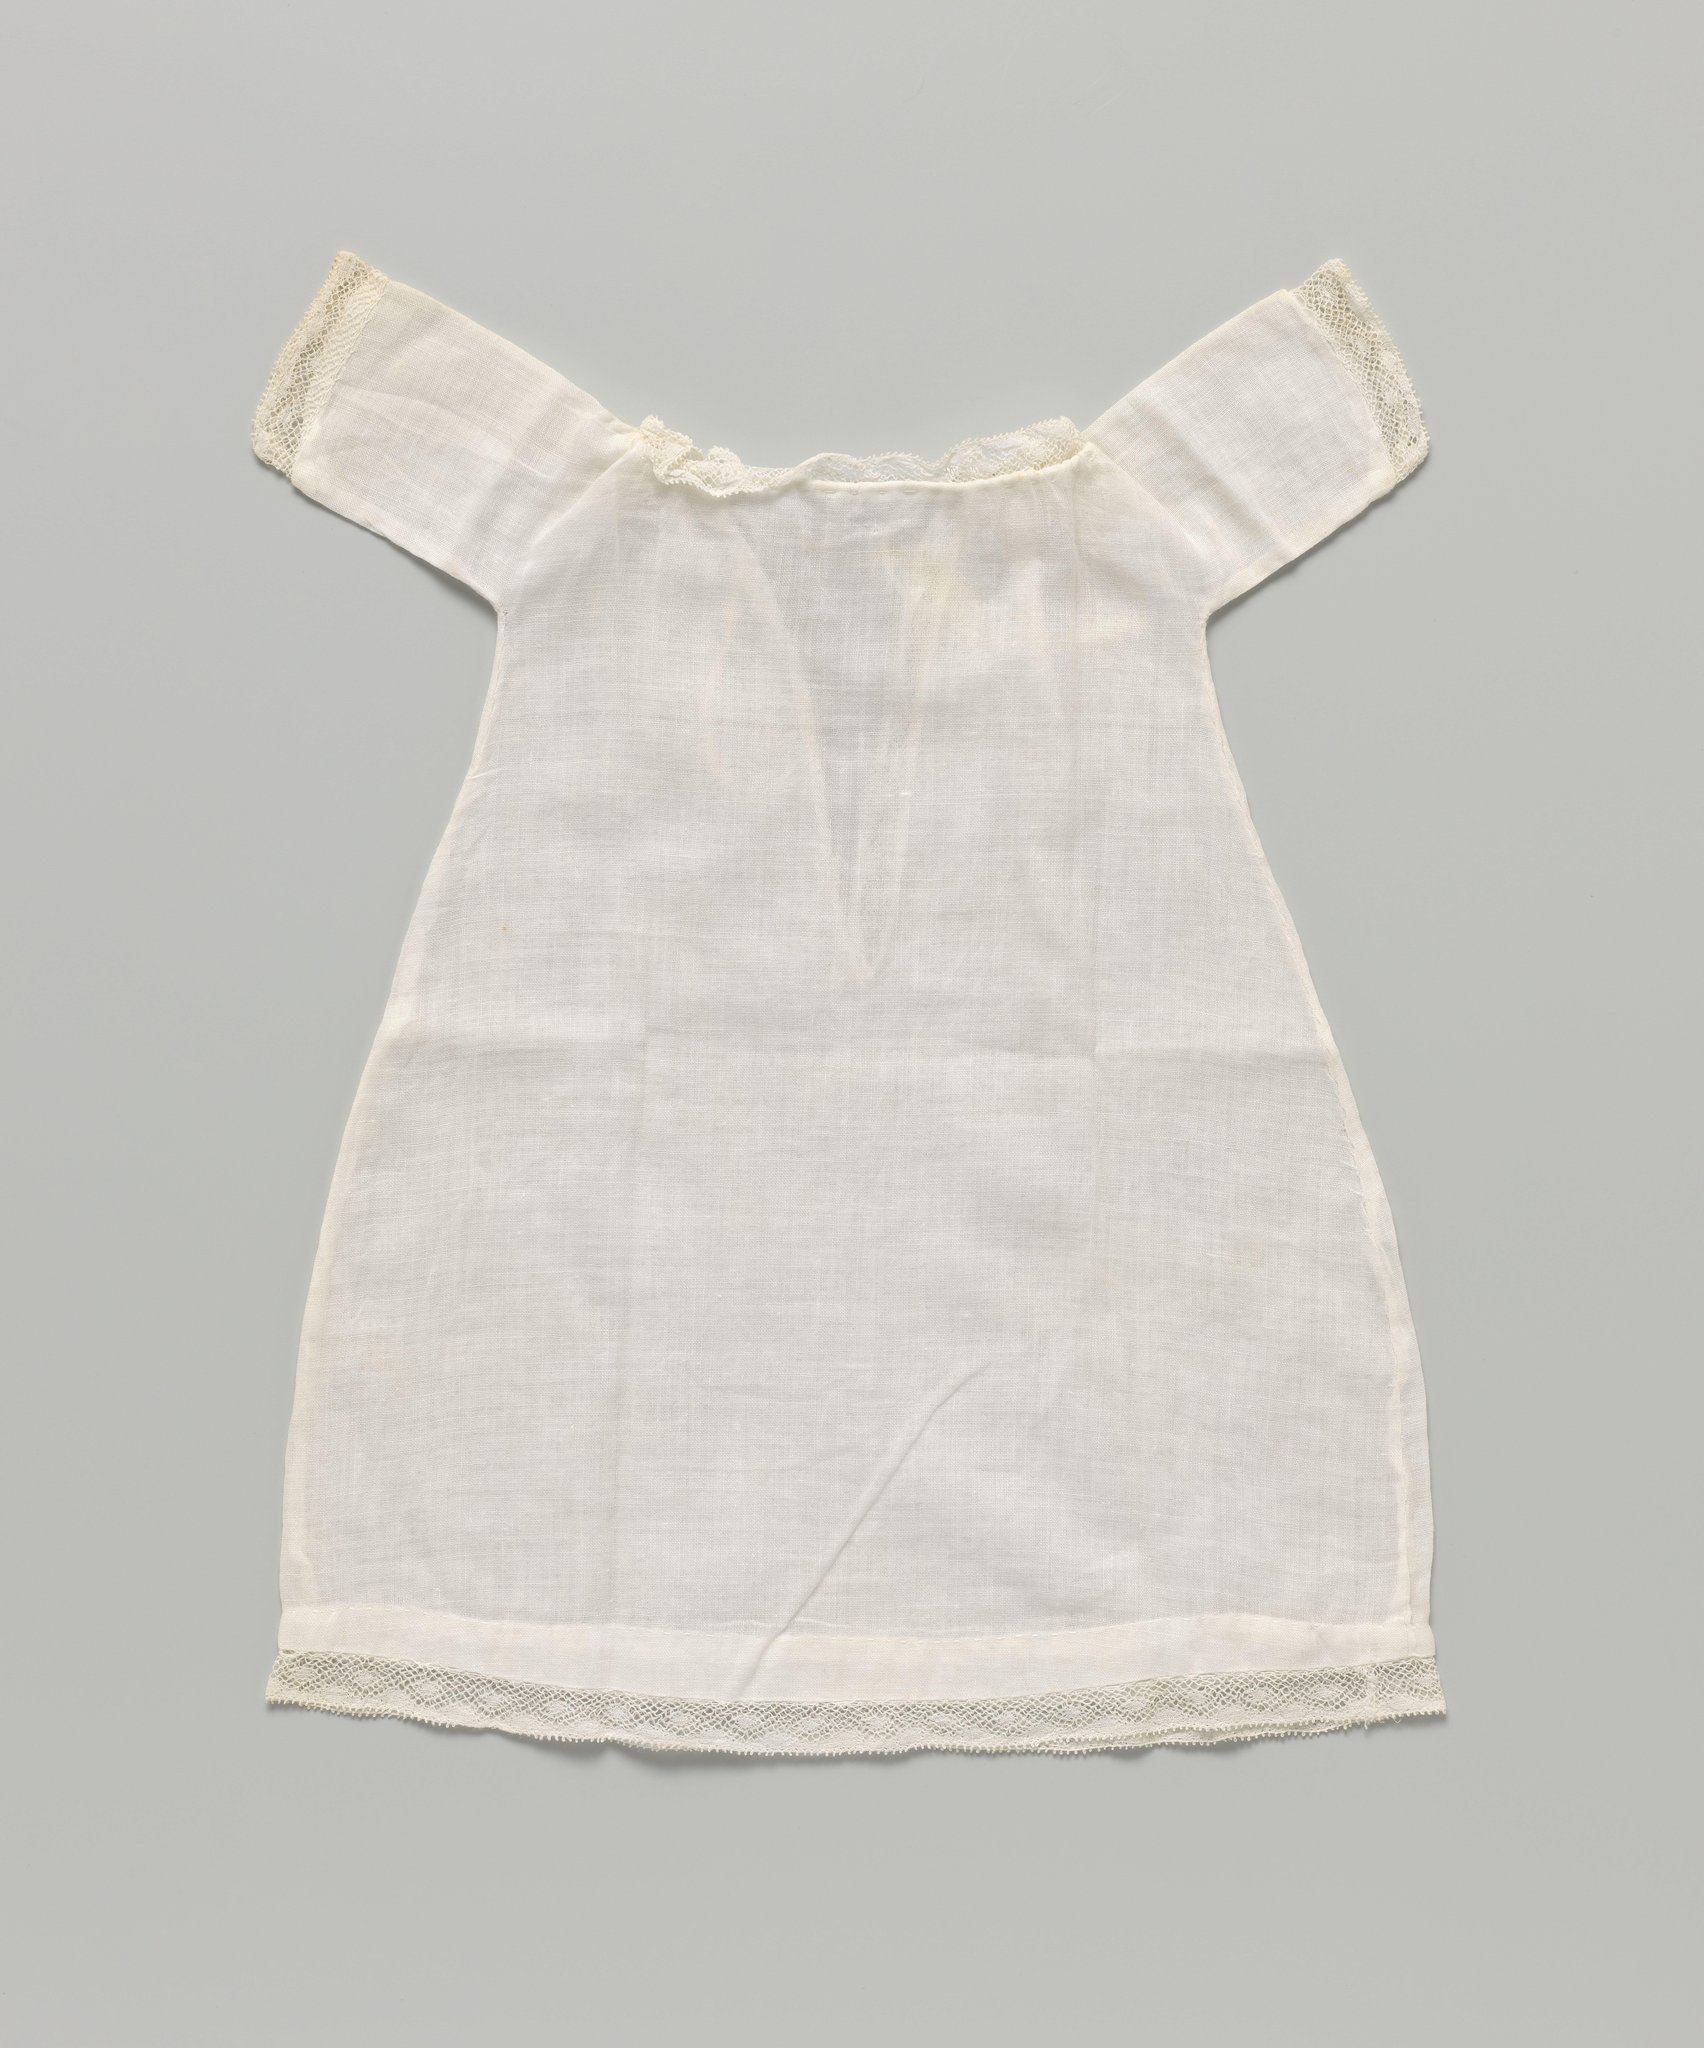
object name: doll's clothing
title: Hemd met korte mouwen en kant langs hals, mouwen en zoom.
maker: Anonymous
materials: textile, linen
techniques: sewing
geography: netherlands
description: Hemd van batist, met korte mouwen; kant langs hals, mouwen en zoom.